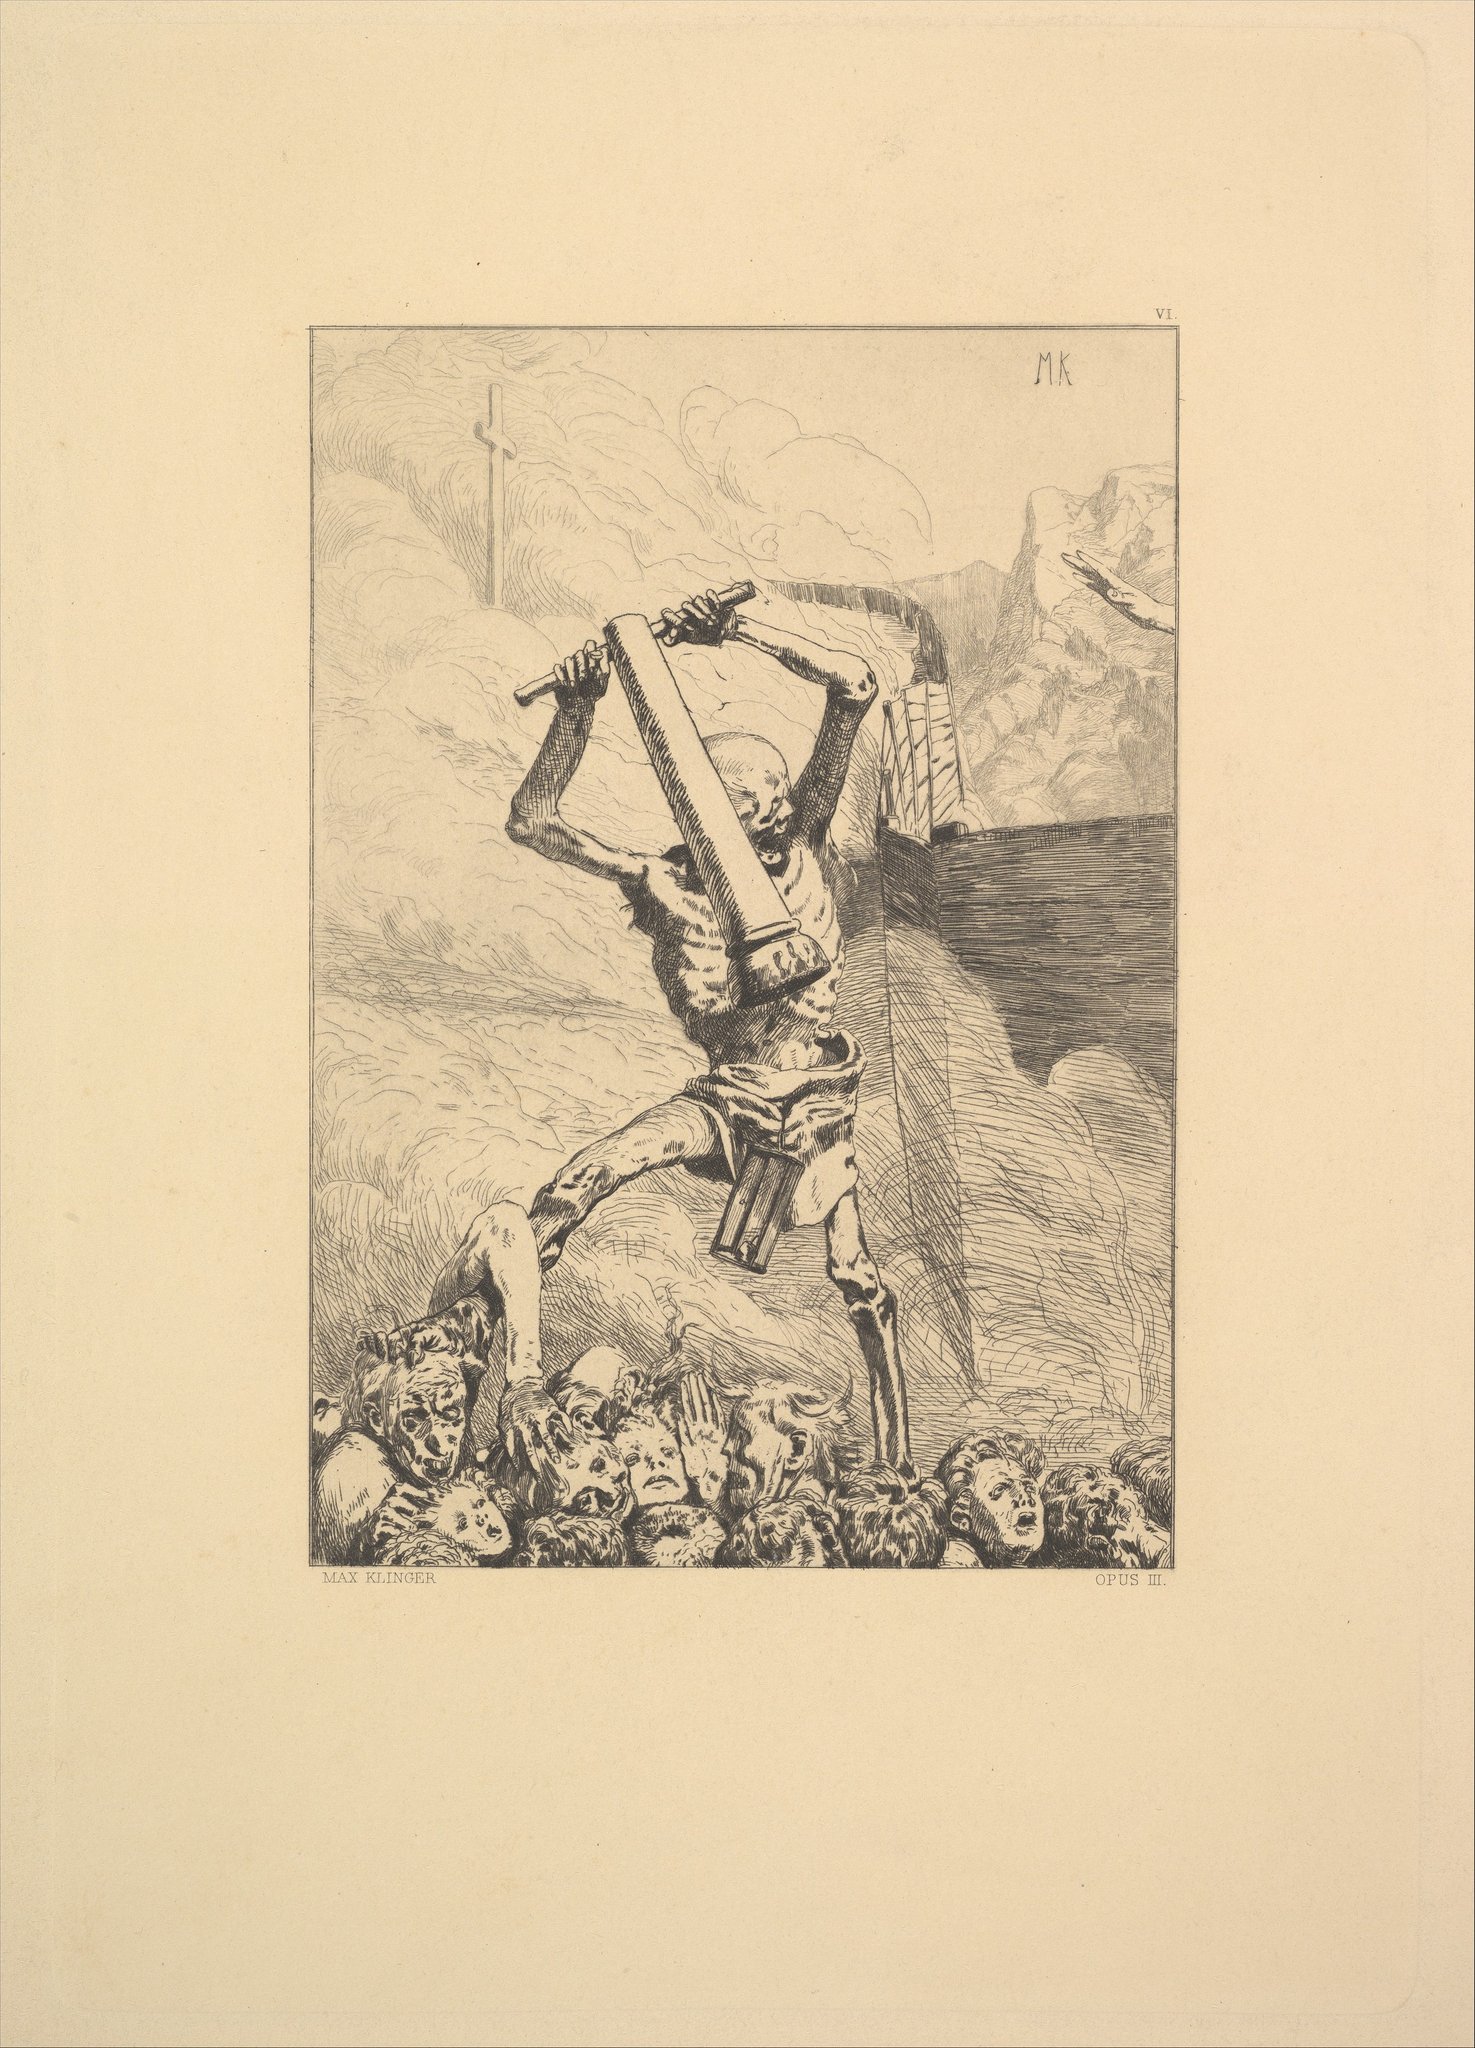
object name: print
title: Dritte Zukunft from Eva und die Zukunft (Rad.-Werk III)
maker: max klinger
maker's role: artist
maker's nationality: german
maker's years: 1857-1920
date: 1898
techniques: etching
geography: germany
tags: skeletons